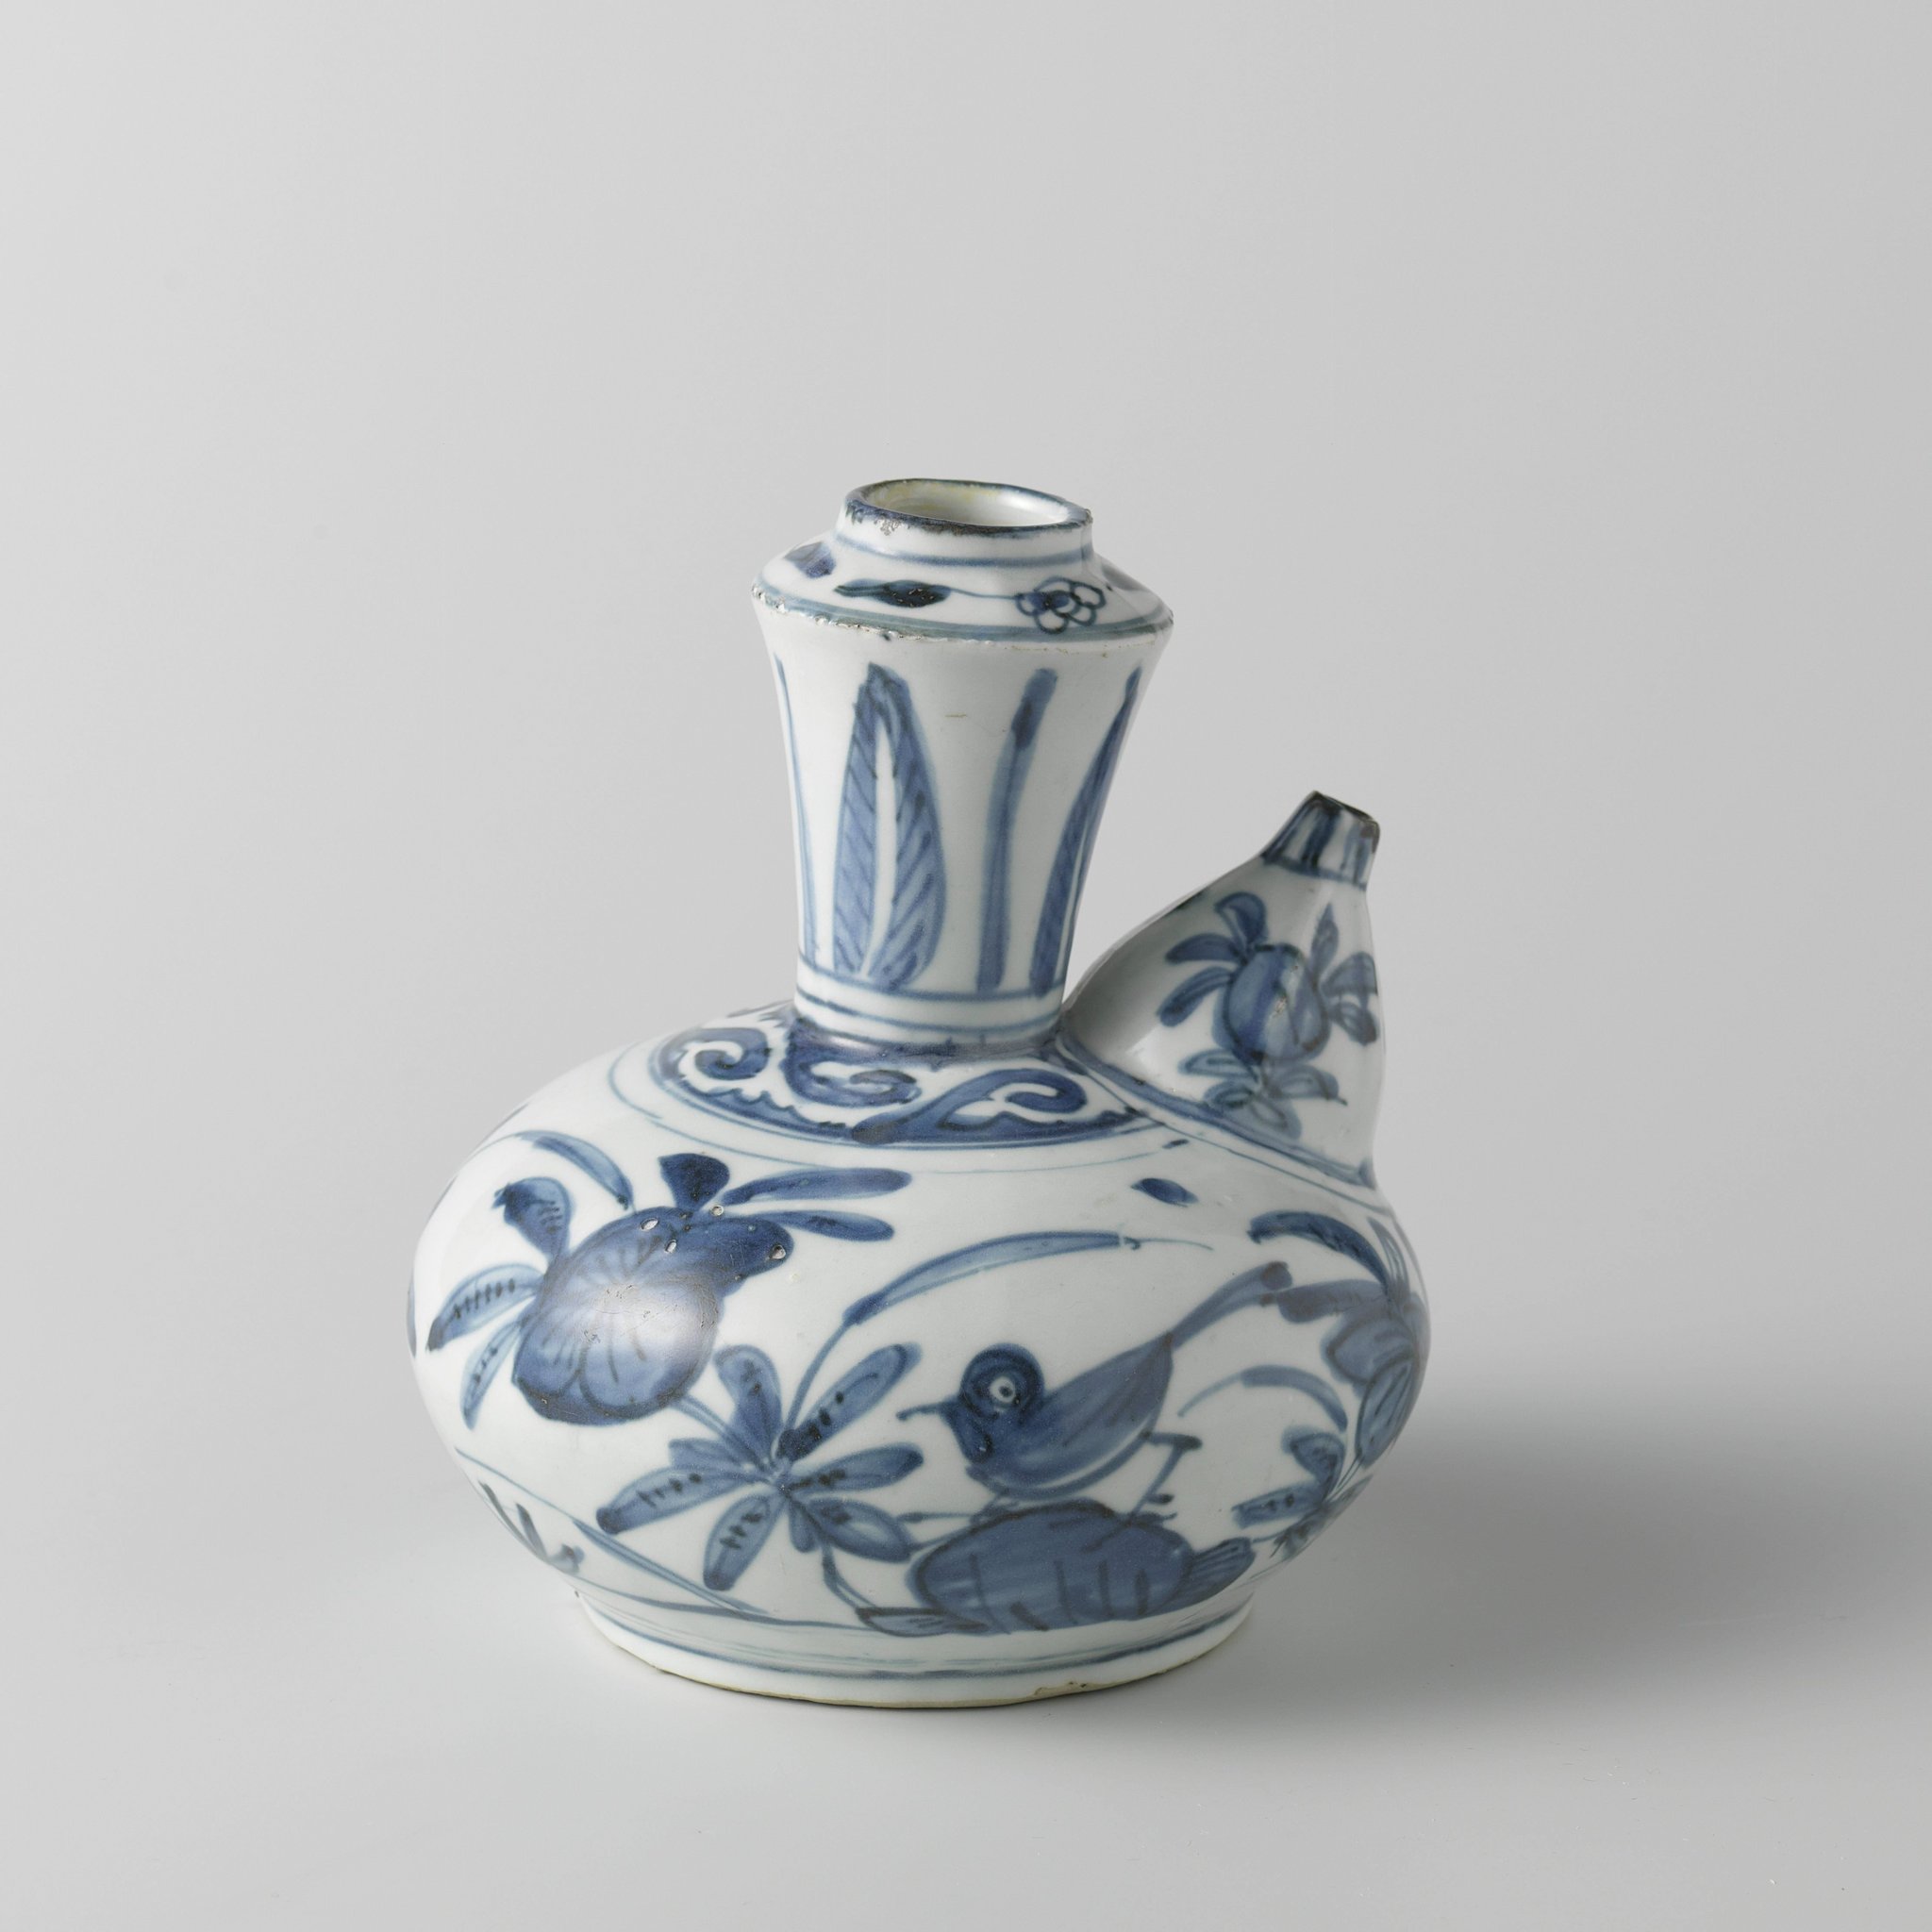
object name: wijnkruik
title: Kendi from the V.O.C.-ship the 'Witte Leeuw'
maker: Anonymous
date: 1613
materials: bone china, cobalt, glaze, paint, porcelain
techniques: firing, turning, vitrification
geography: jingdezhen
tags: birds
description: Kendi van porselein uit V.O.C.-schip de 'Witte Leeuw', 100 procent aanwezig. Kendi met een gedrukt bol lichaam, een grote tuit en een naar boven breder wordend handvat met een opstaand randje rond de opening. Gedecoreerd in onderglazuur blauw met een doorlopende voorstelling van een vogel op een rots tussen de planten op de buik, gestileerde ranken uitgespaard in wit tegen een blauwe achtergrond op de schouder en staande bladeren op de hals. De tuit met perziktakken. De scherf is glasachtig wit en kent weinig ingebakken vuil. De bodem is geglazuurd en de voetring is recht en gefacetteerd. Er zijn meer dan 20 korrels ovenzand aangetroffen. Kraakporselein in blauw-wit.